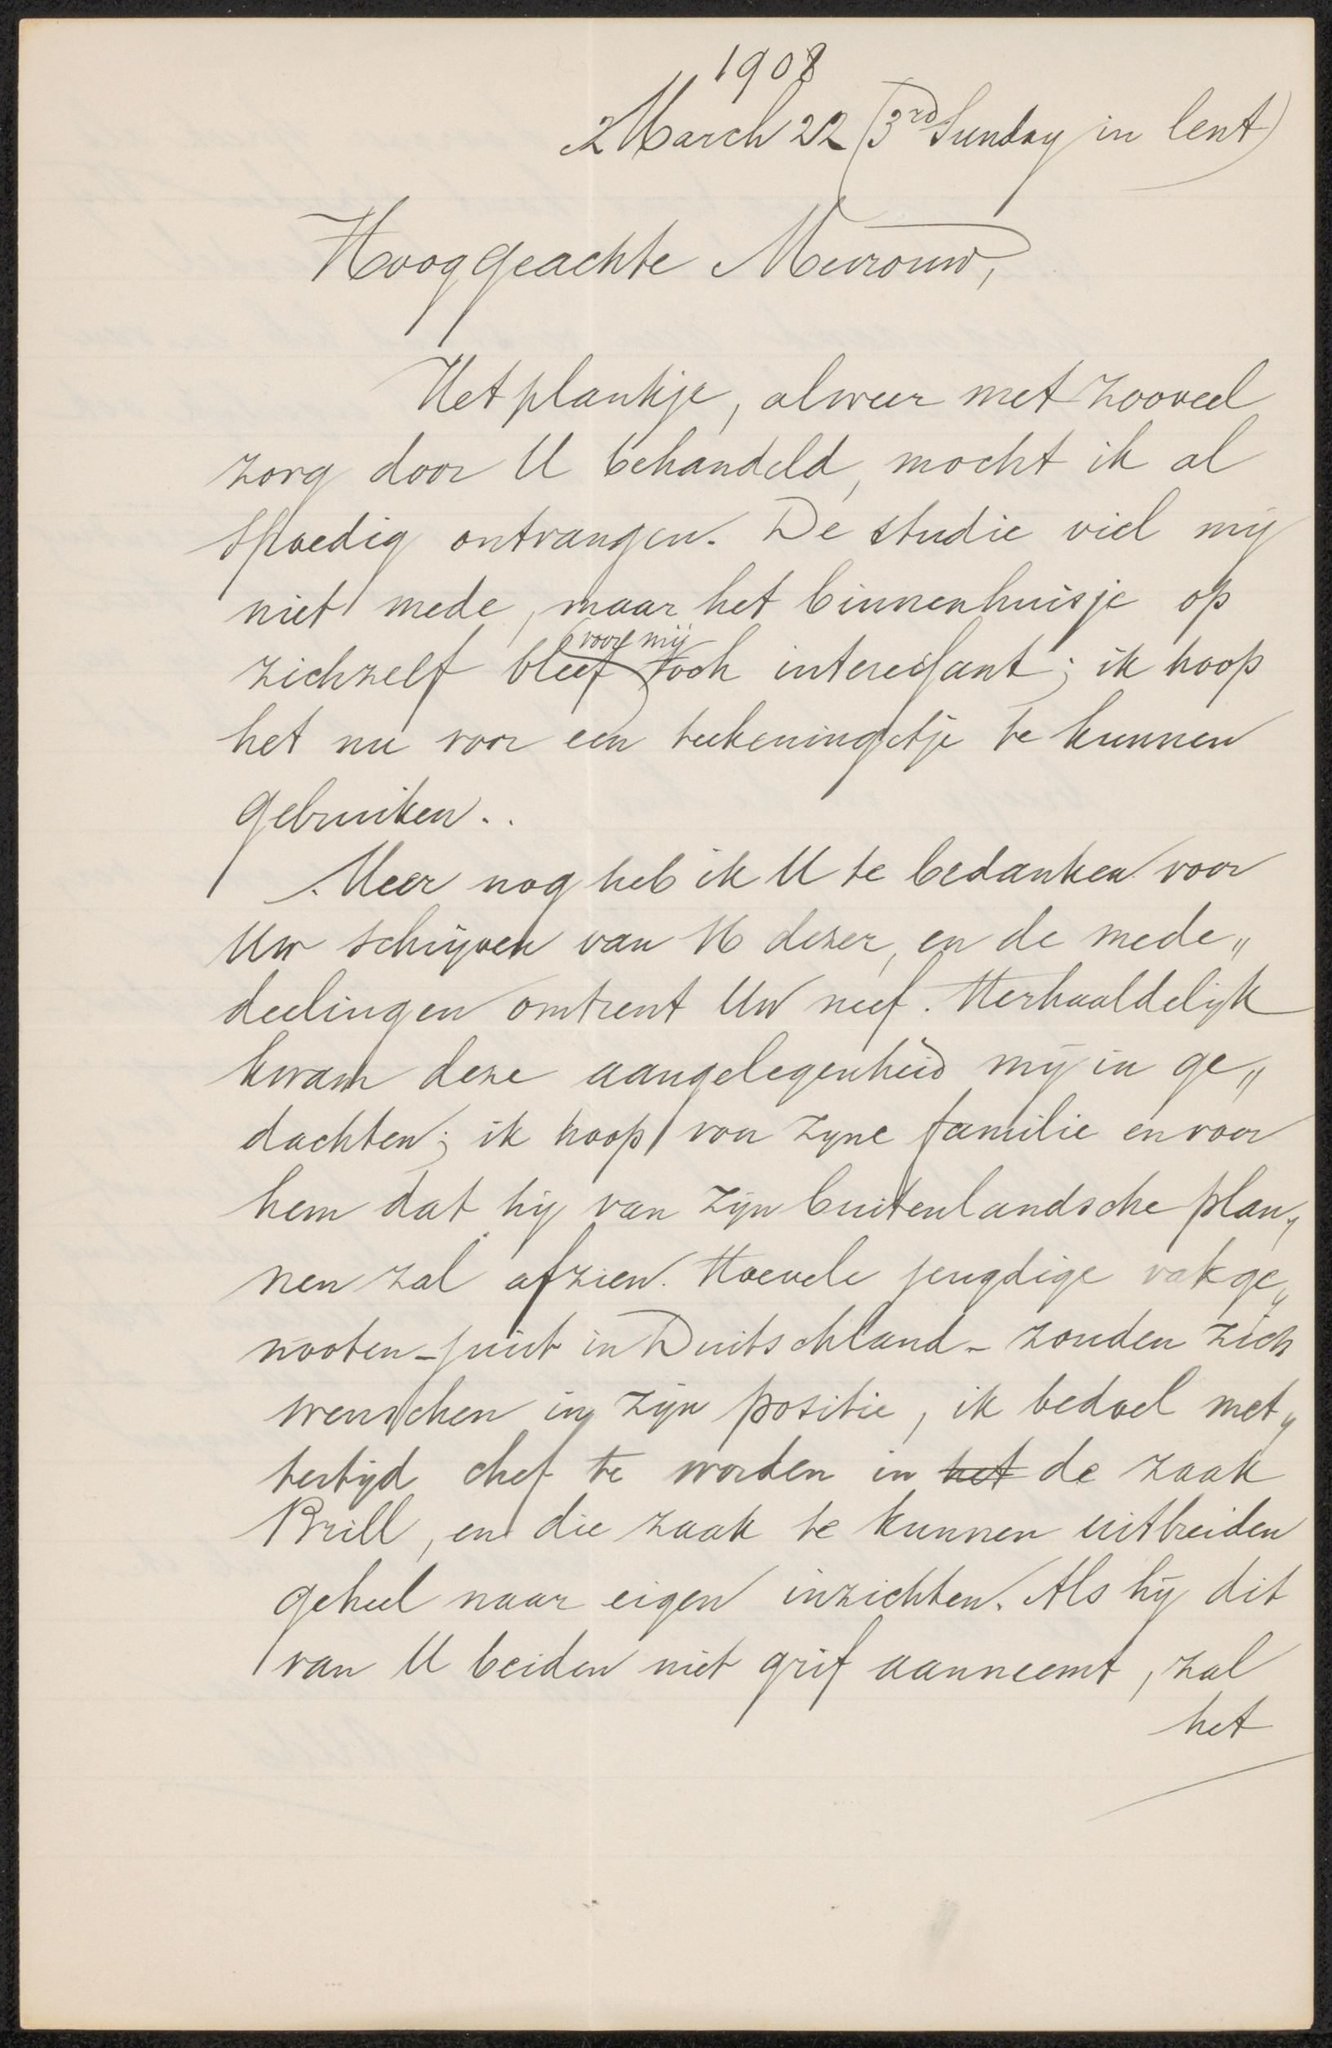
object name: letter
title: Brief aan Anne Antoinette Weber-Van Bosse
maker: august allebé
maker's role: draughtsman, print maker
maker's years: 1838-1927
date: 1908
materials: ink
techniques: pen, writing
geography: amsterdam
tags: rotterdam, charles albert de burlet, amsterdam, anne antoinette weber-van bosse, antwerp, rome, print maker, draughtsman, paul bril, drawing, diseases